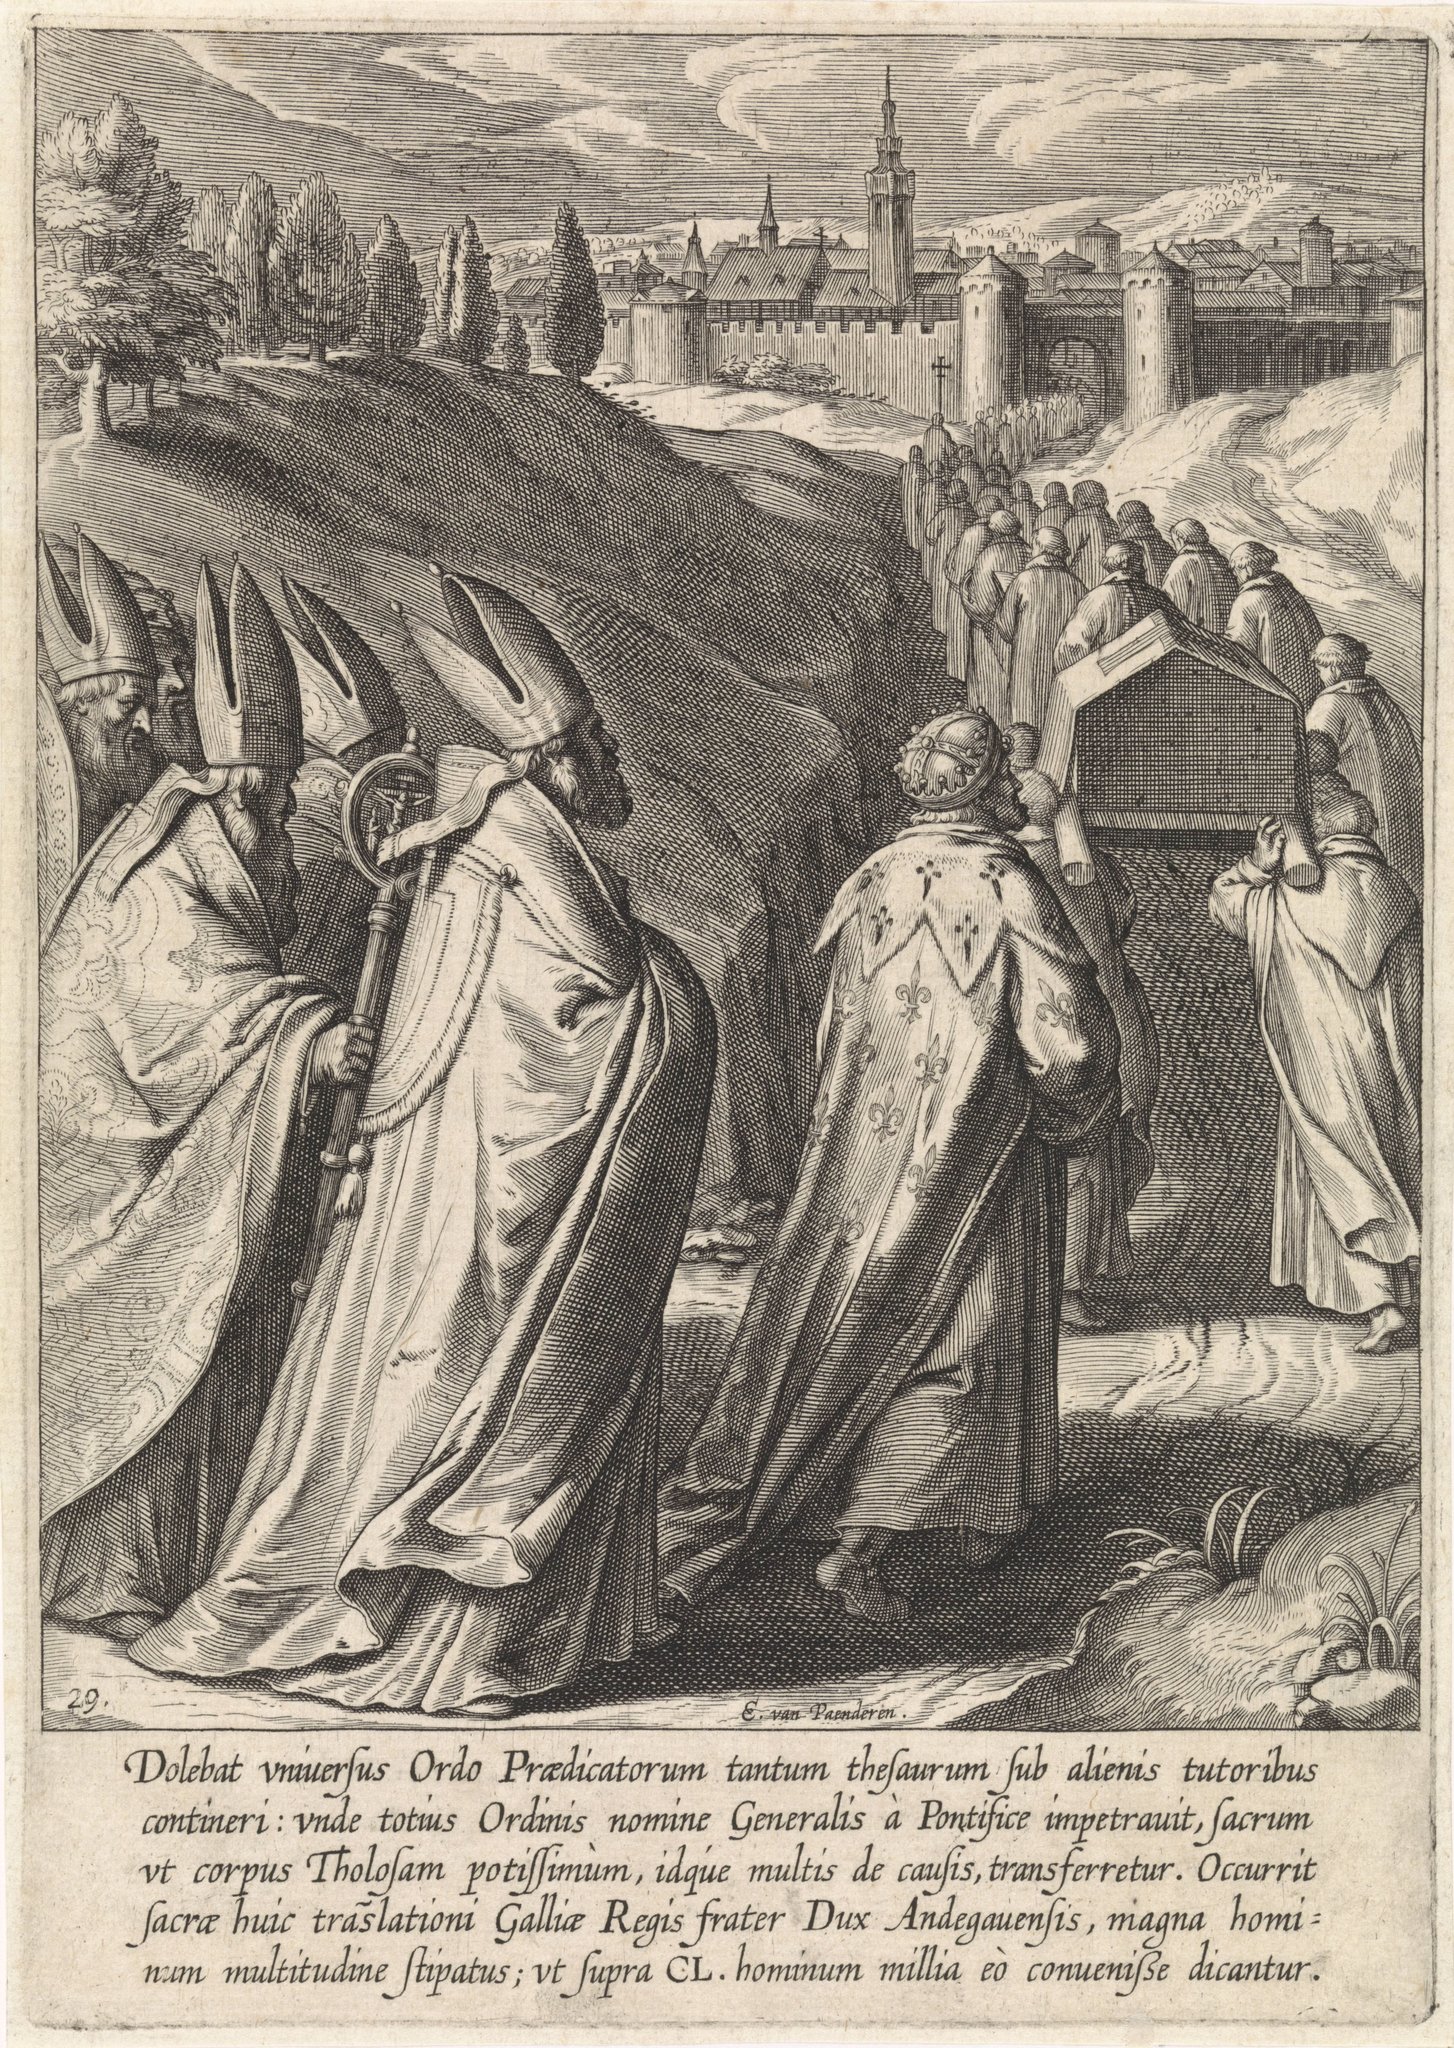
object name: print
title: Het leven van de heilige Thomas van Aquino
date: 1610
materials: paper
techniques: engraving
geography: antwerp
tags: the dominican theologian, 'angelic doctor' thomas of aquino; possible attributes: book, (chain with) sun, dove, girdle of chastity, lily, model of church, monstrance (or chalice), mitre (under feet), star (on breast) - finding, transportation of relics of male saint, cortege, funeral procession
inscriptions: collector's mark: Lugt 2228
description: Landschap met vier monniken die de kist van Thomas van Aquino dragen, voorgegaan door verschillende monniken. Achter hen volgen diverse bisschoppen en een koning. Op de achtergrond een gezicht op Toulouse. In de marge een vijfregelig onderschrift in het Latijn. Negenentwintigste prent uit een serie van dertig prenten die het levensverhaal van Thomas van Aquino verbeelden.